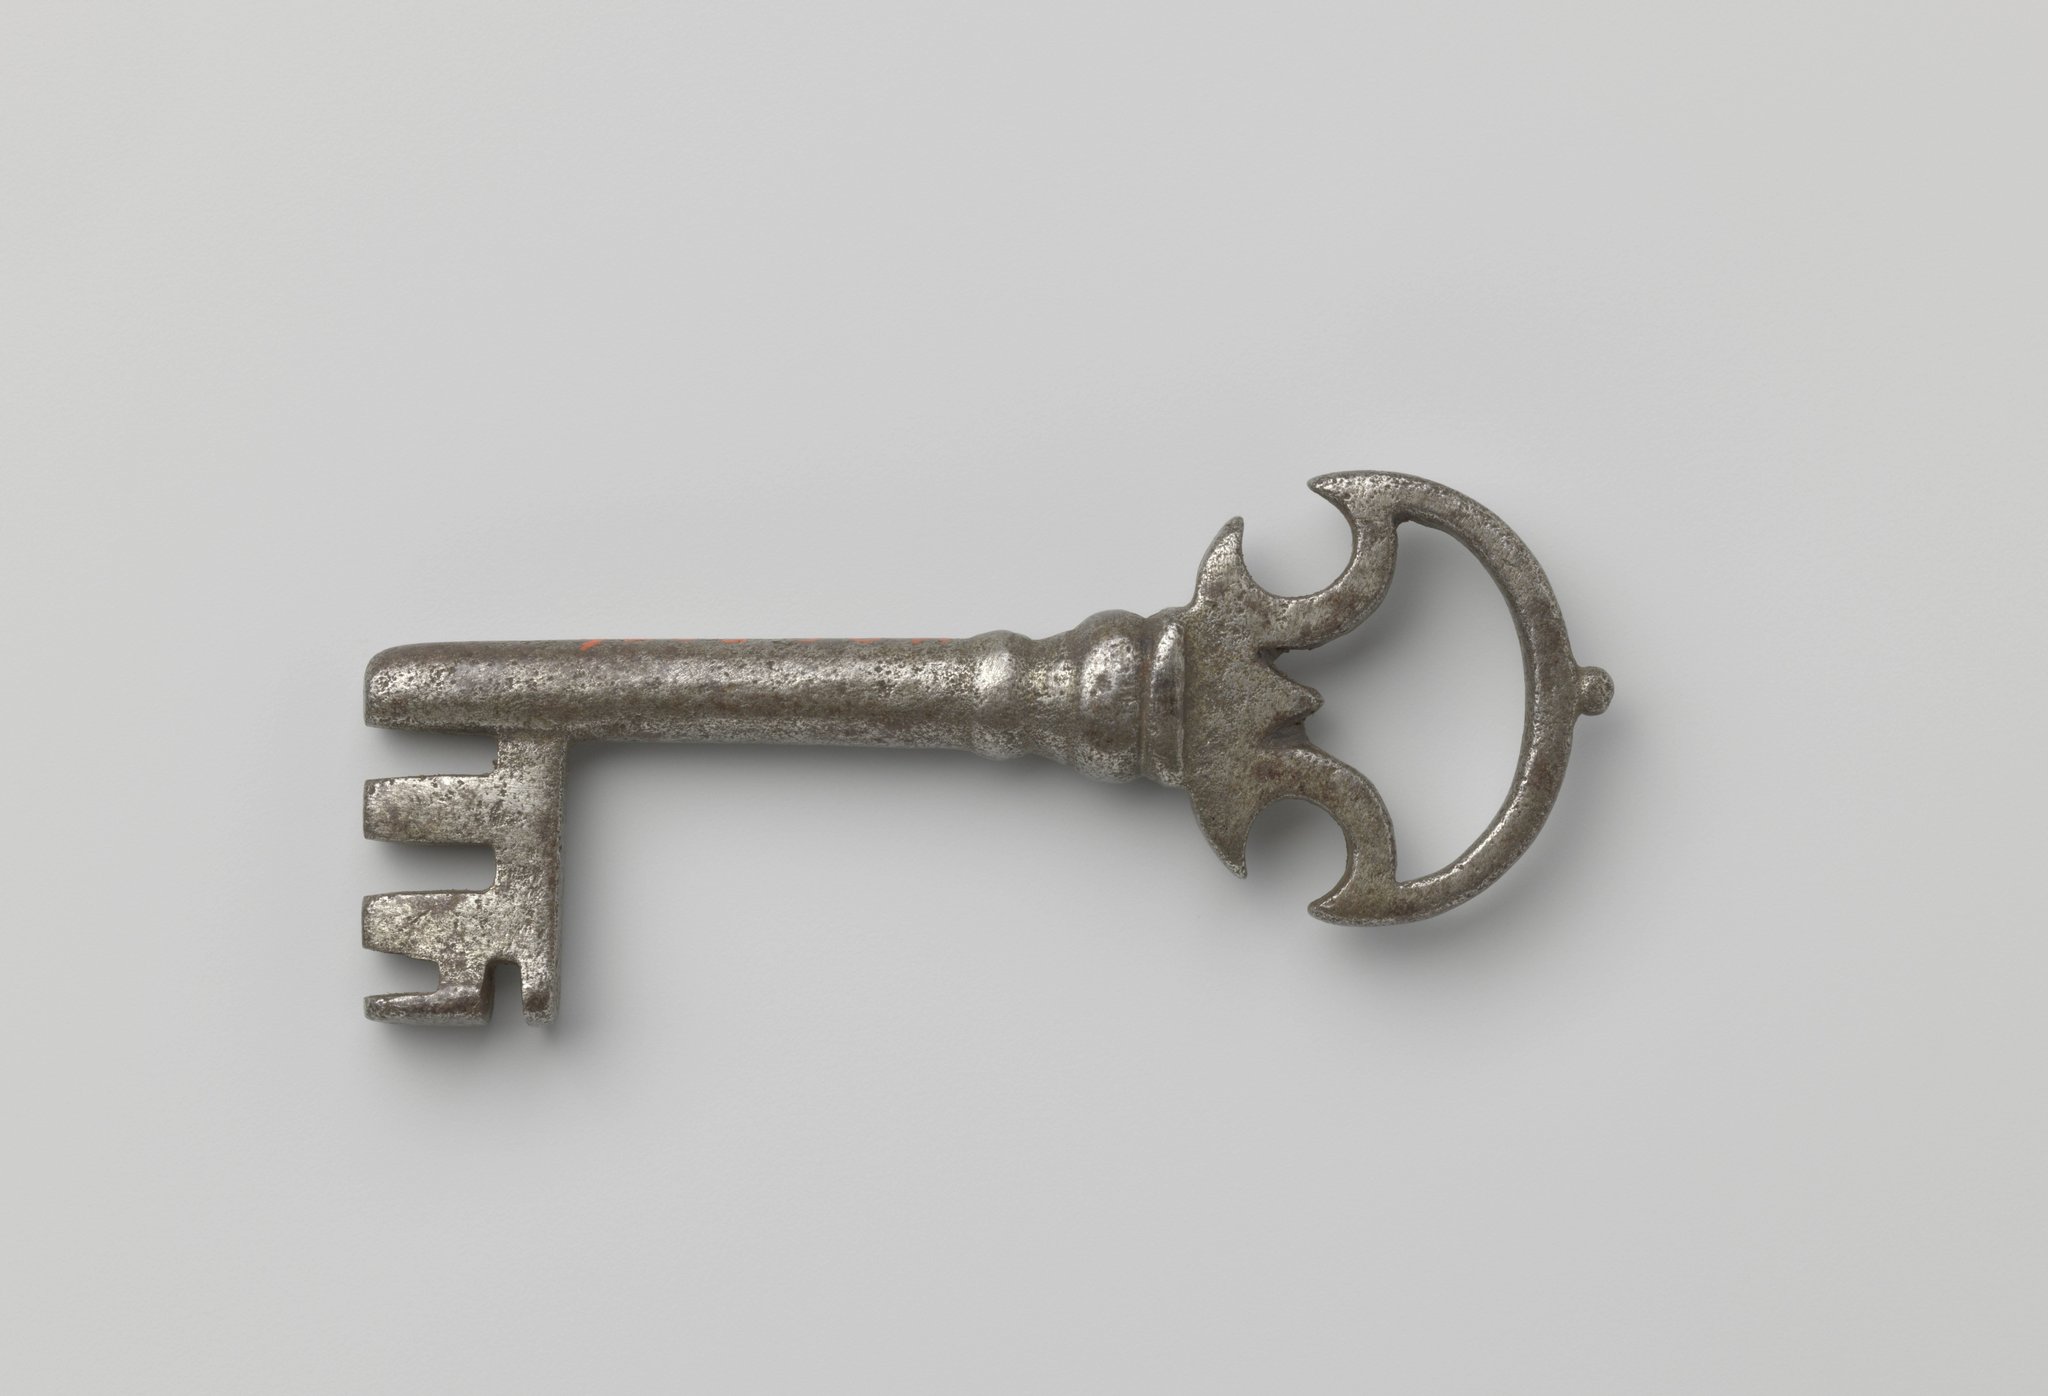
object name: key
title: Sleutel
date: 1600-1699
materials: iron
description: Sleutel met beugelvormig oog bekroond door een knopje.